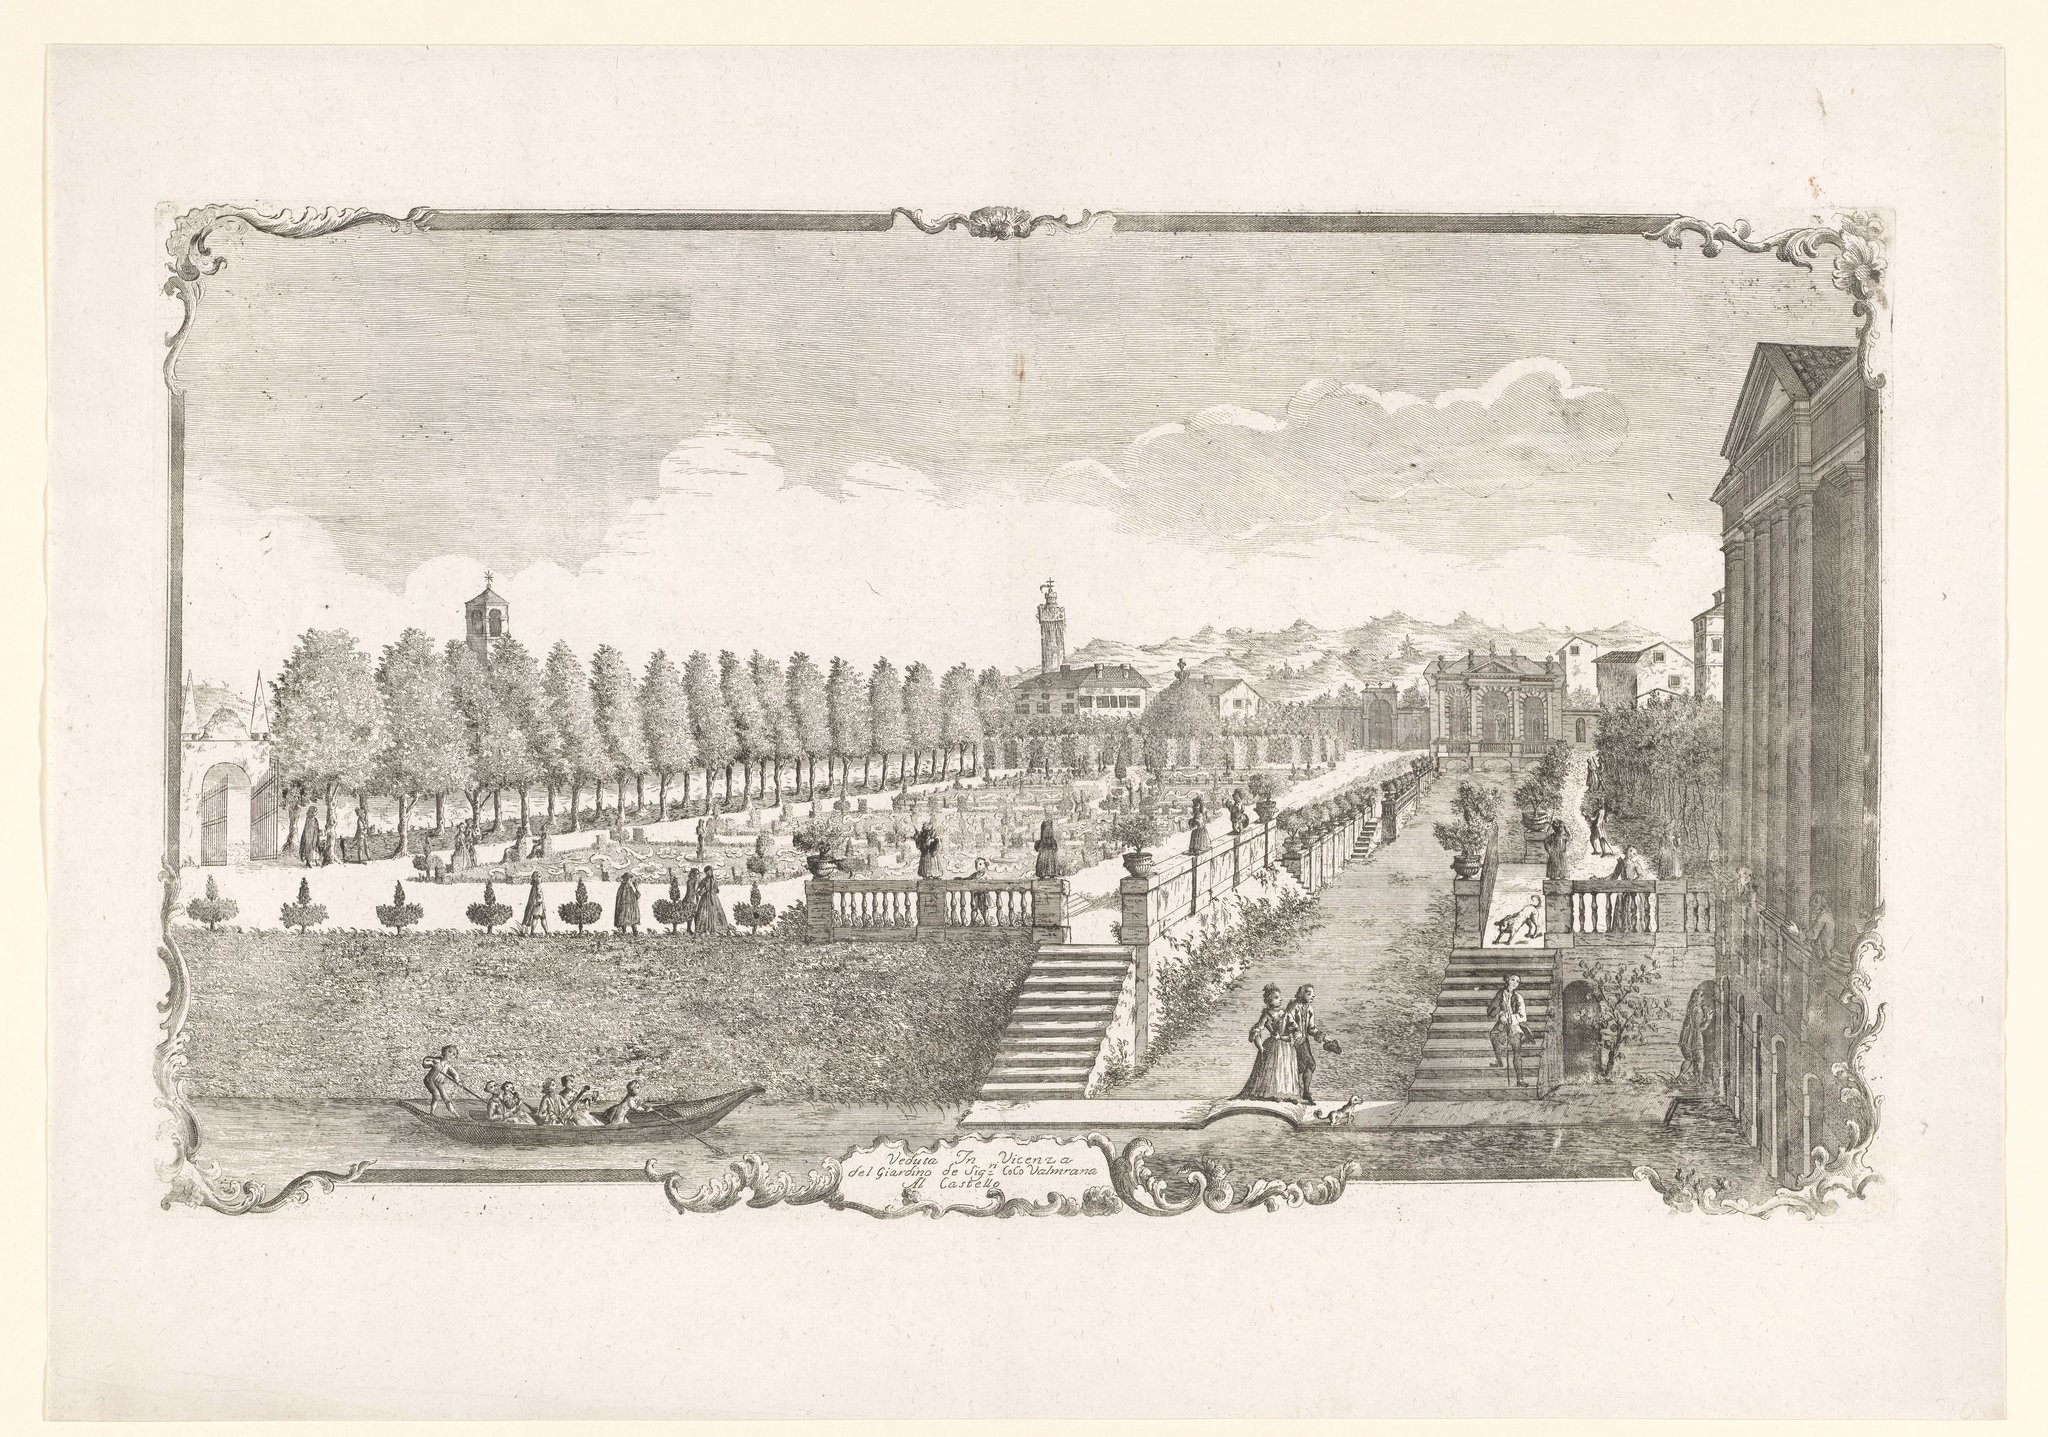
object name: print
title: Vedute vicentine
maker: cristoforo dall acqua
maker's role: draughtsman, print maker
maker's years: 1734-1787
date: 1744-1787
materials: paper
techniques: etching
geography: italy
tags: city-view, and landscape with man-made constructions, garden, gondola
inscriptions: collector's mark: Lugt 2228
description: Gezicht op de tuin van Coco Valmarana in Vicenza. Figuren flaneren door de tuin. Op de voorgrond figuren in een gondel die langs de tuin varen. Onder titel in cartouche.